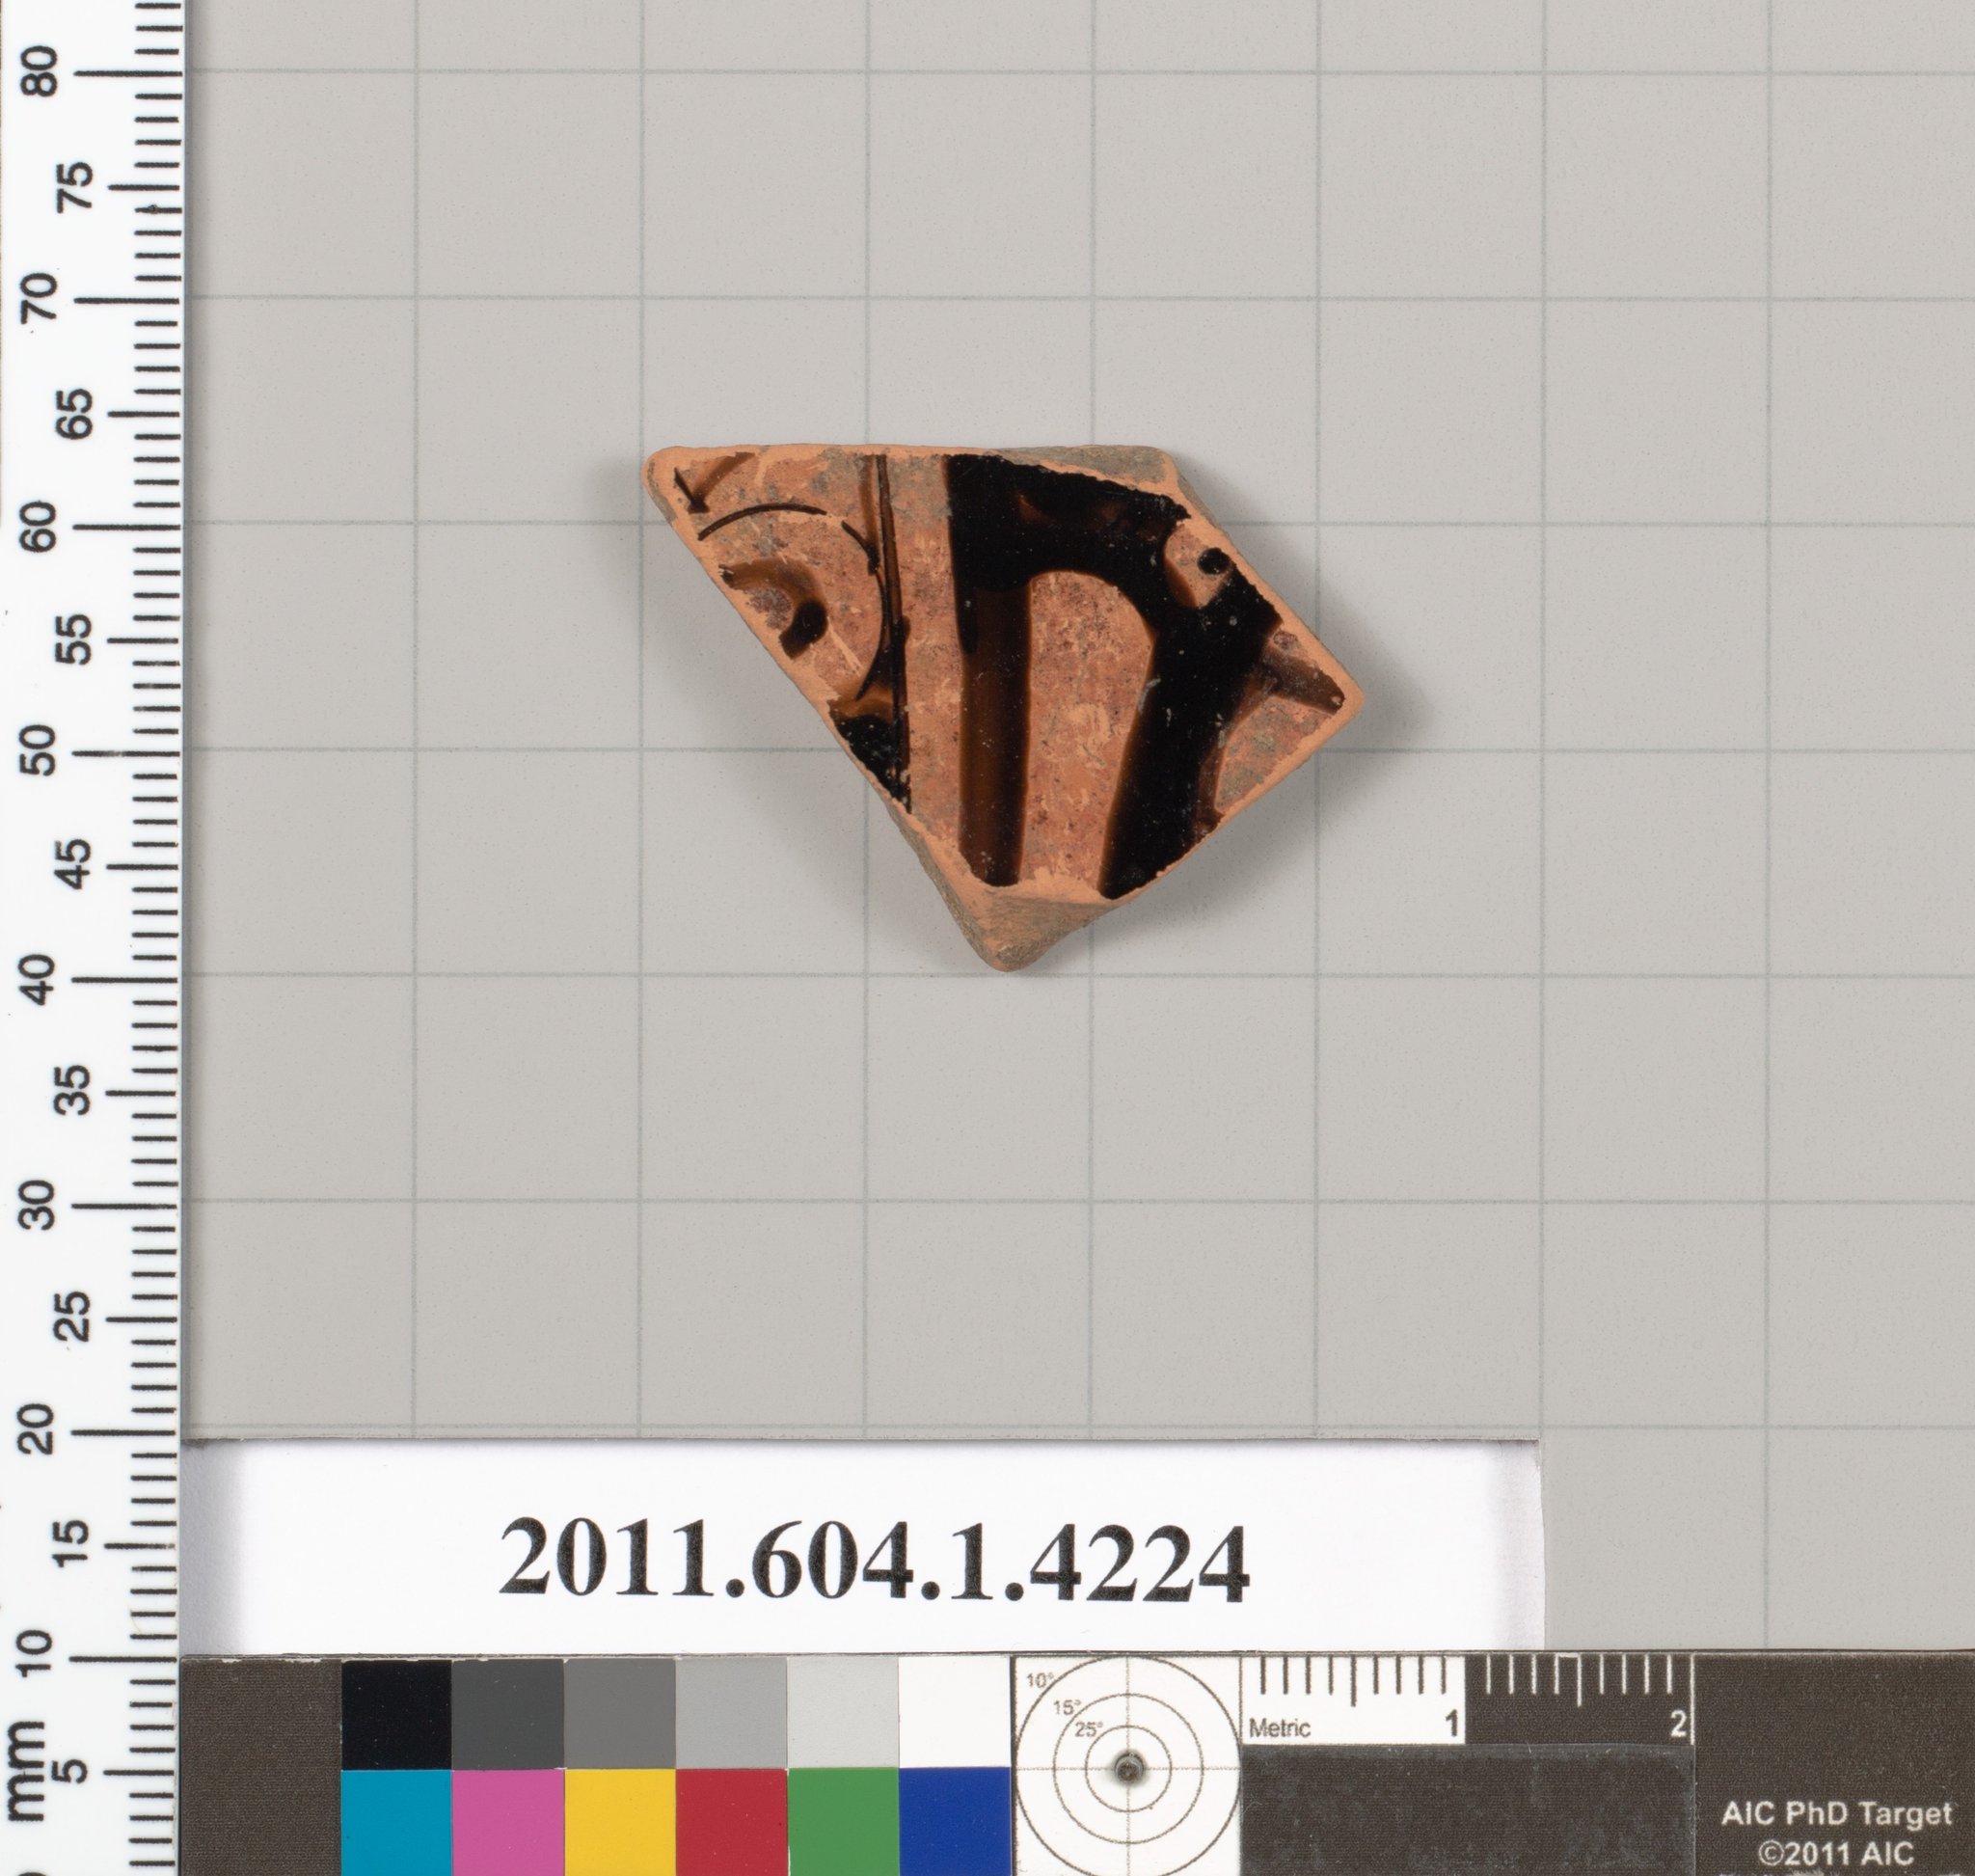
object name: kylix fragment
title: Terracotta fragment of a kylix (drinking cup)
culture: greek, attic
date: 475-451 BCE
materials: terracotta